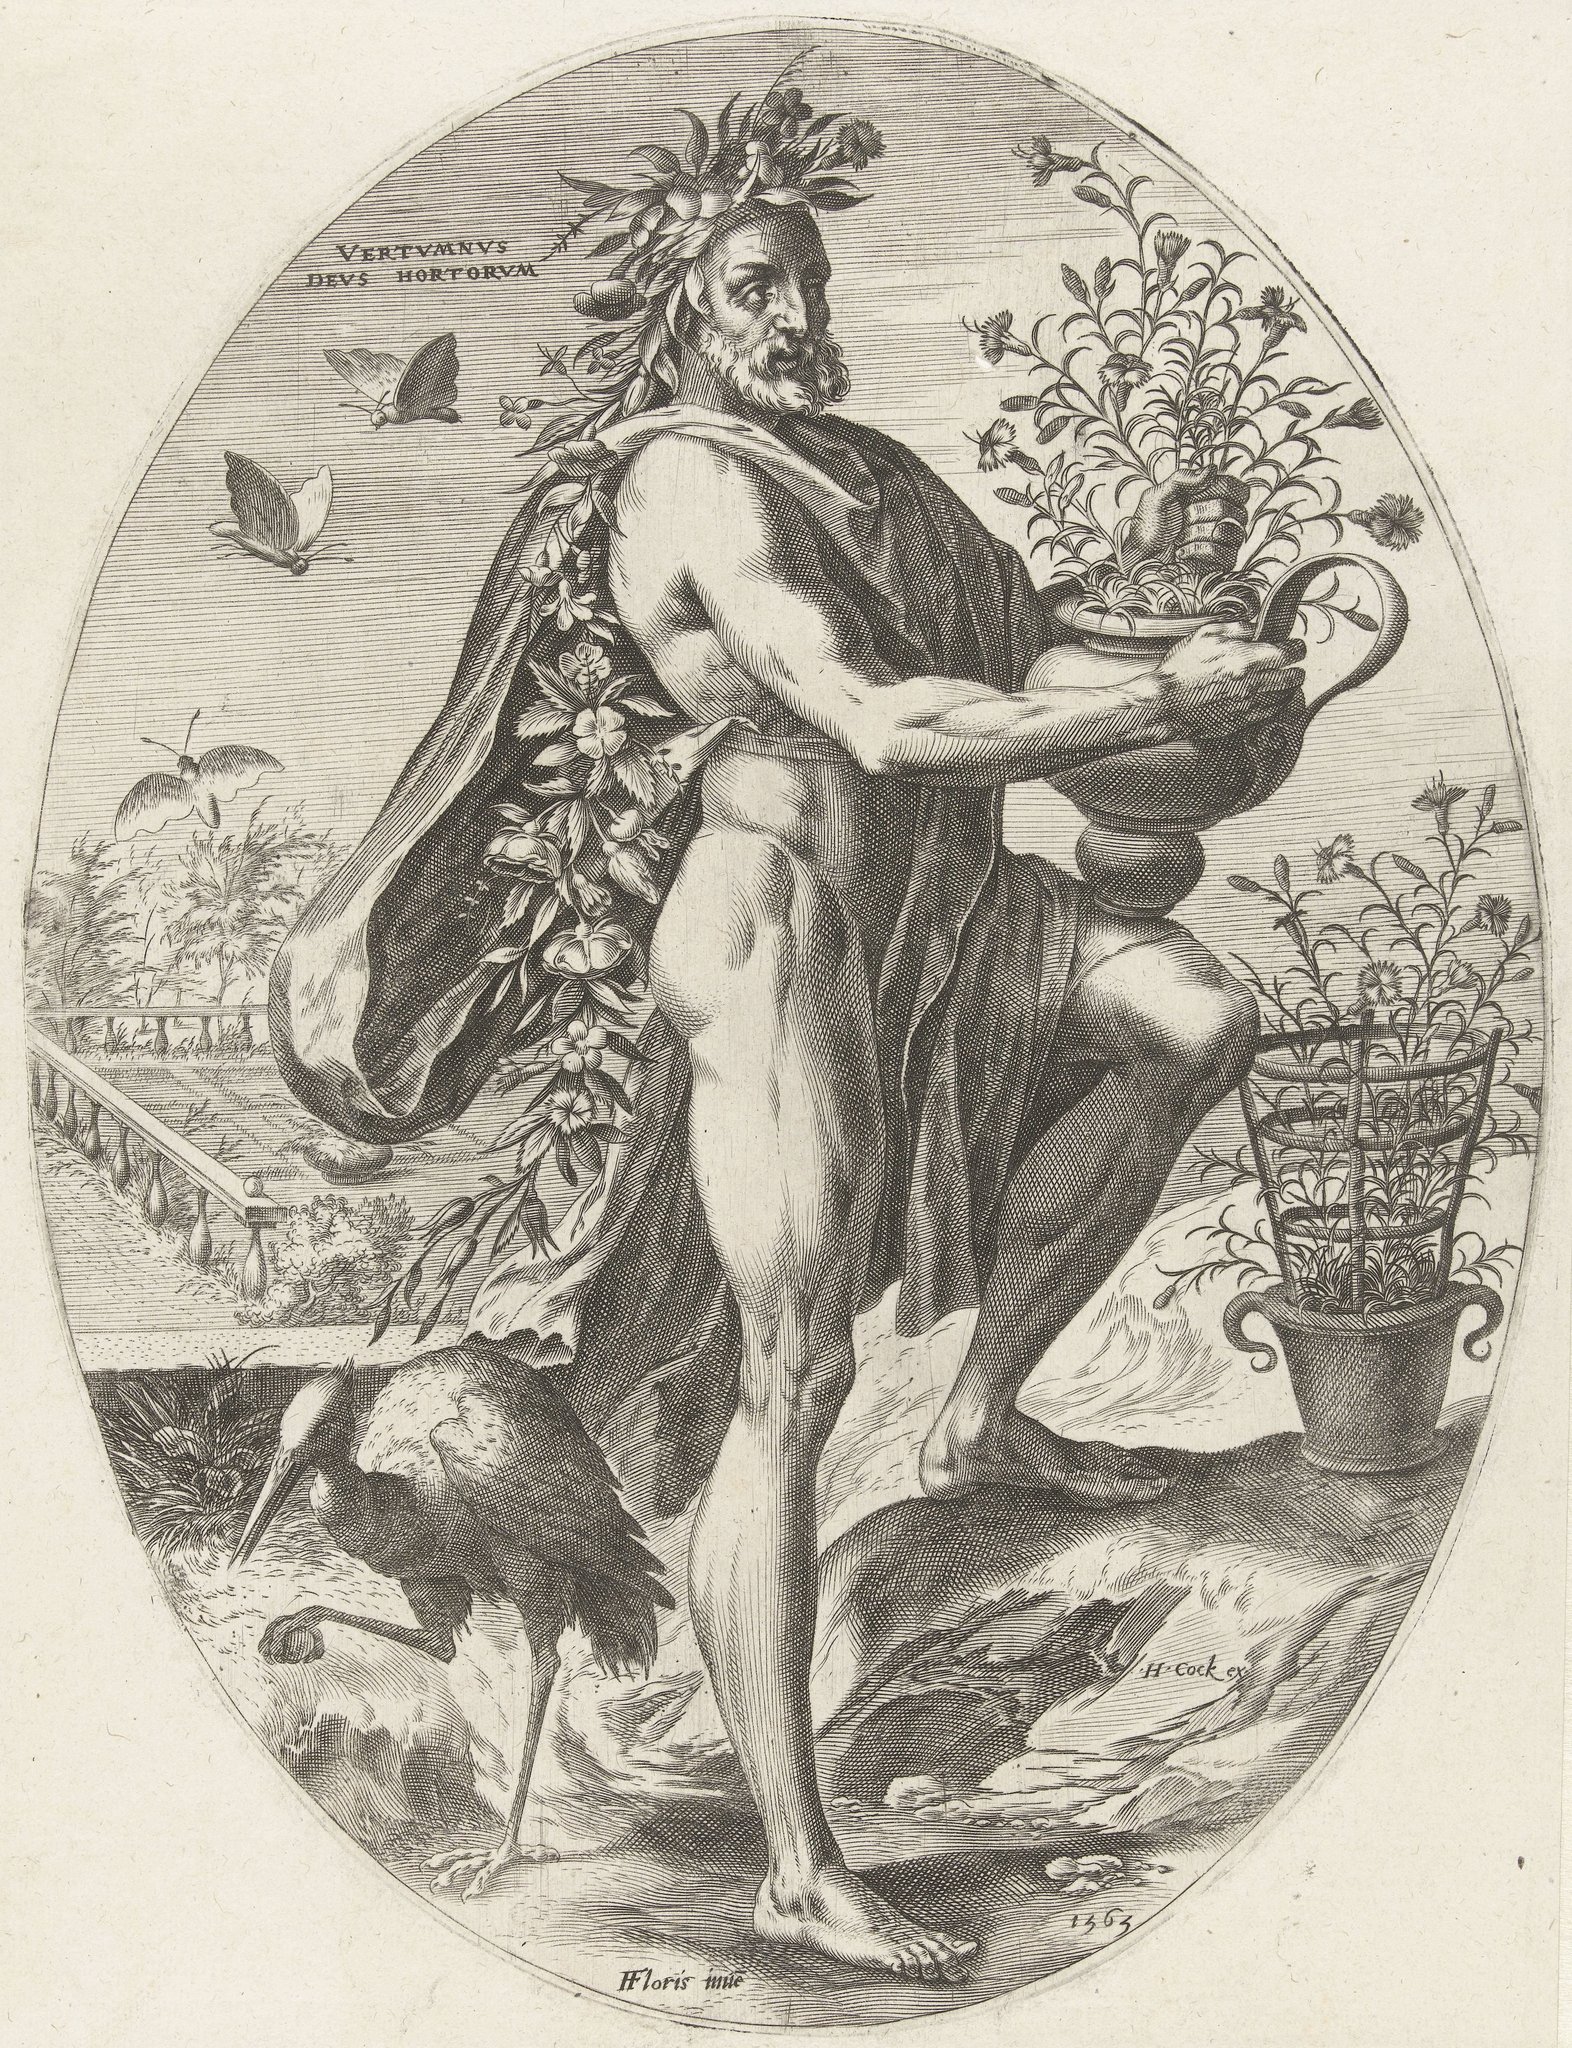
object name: print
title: Goden van de landbouw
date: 1565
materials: paper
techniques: engraving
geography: antwerp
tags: (story of) vertumnus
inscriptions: collector's mark: Lugt 2542, collector's mark: Lugt 2228, collector's mark: Lugt 1379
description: Vertumnus, hier de god van de tuinen, is planten aan het verpotten. Naast hem staat een reiger op de grond. Op de achtergrond een tuin en vlinders.